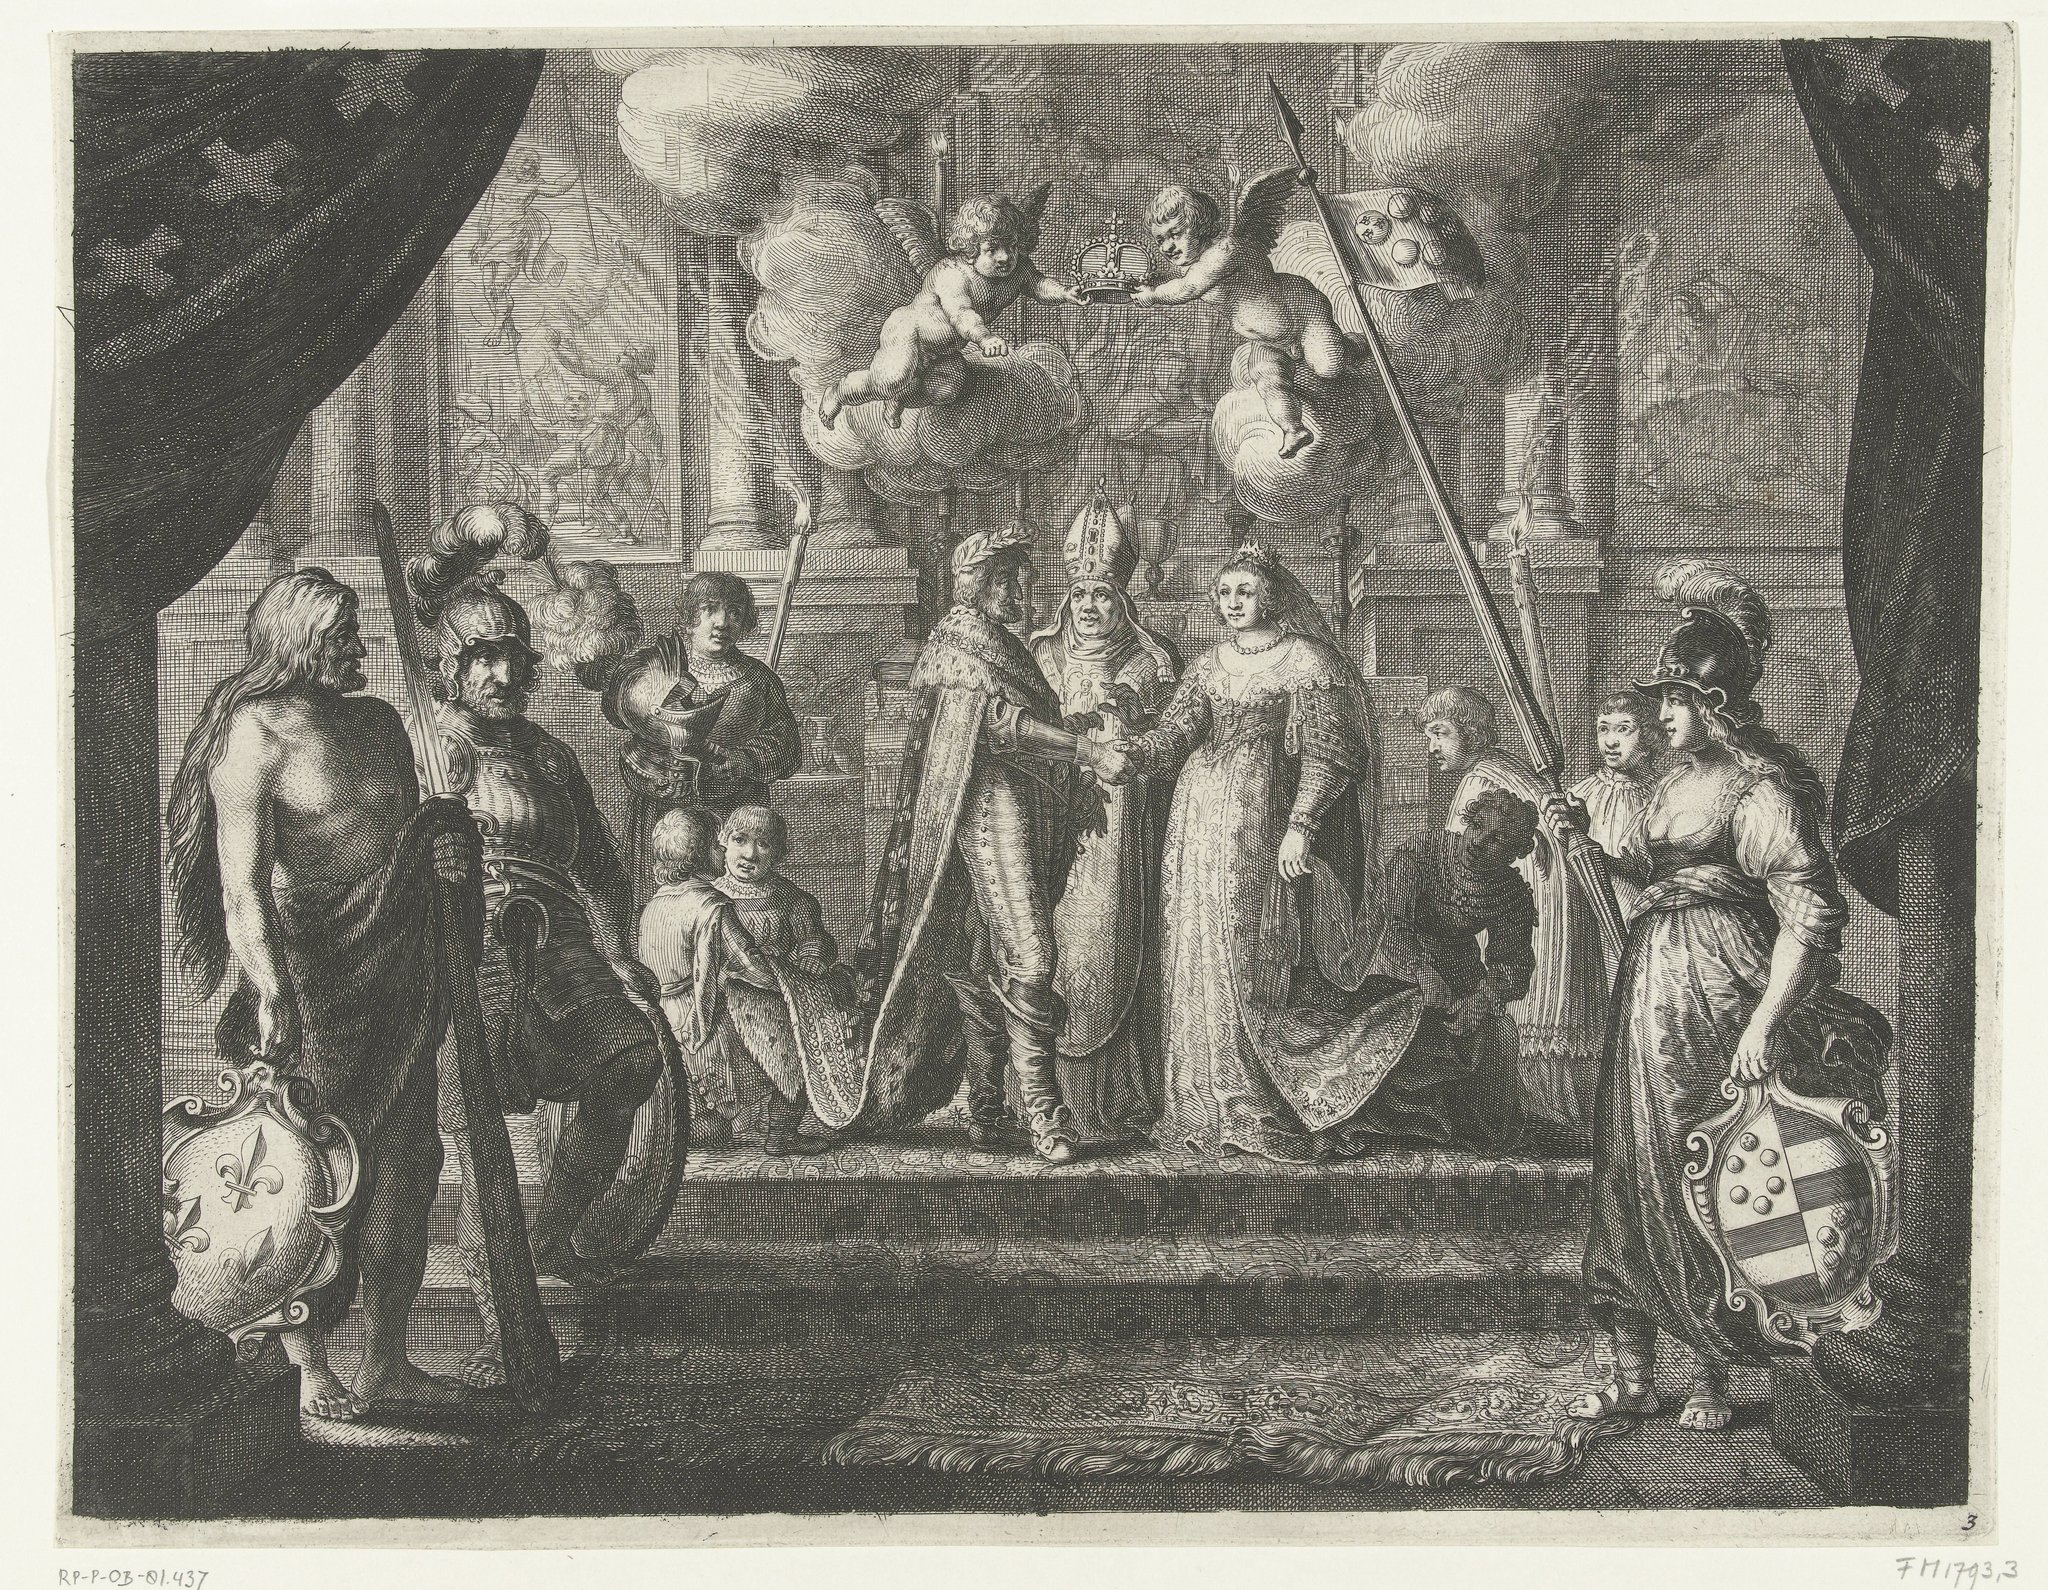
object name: print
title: Feestelijkheden bij het bezoek van Maria de' Medici aan Amsterdam in 1638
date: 1638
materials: paper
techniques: engraving, etching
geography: amsterdam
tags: cologne, print maker, maria de' medici, paris, hendrik iv (koning van frankrijk en navarra), triumphal entry and public reception, pageant, 'entrée solennelle', 'joyeuse entrée', blessing the married couple, (civil) marriage ceremonies, amsterdam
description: Prent ook gebruikt in:* Baerle, Caspar van. Medicea hospes, sive descriptio publicae gratulationis, qua Serenissimam, Augustissimamque Reginam, Mariam de Medicis (…). Amsterdam: Johannes en Cornelis Willemsz. Blaeu, 1638. En in: Baerle, Caspar van. Marie de Medicis, entrant dans Amsterdam : ou, histoire de la reception faicte à la Reyne Mere du Roy tres-Chrestien (…). Amsterdam: Johannes en Cornelis Willemsz. Blaeu, 1638. En in: Baerle, Caspar van en Joost van den Vondel. Blyde inkomst der allerdoorluchtighste koninginne, Maria de Medicis t' Amsterdam. Vertaelt uit het Latijn (…). Amsterdam: Johannes en Cornelis Willemsz. Blaeu, 1639. * Doorgaans zijn de prenten in de bovengenoemde publicaties rechtsonder genummerd (van de huidige prent is dat de derde bekende staat). Maar er zijn ook exemplaren waarin eerdere, ongenummerde, staten van de prenten (van de huidige prent de eerste en tweede bekende staat) zijn ingebonden.